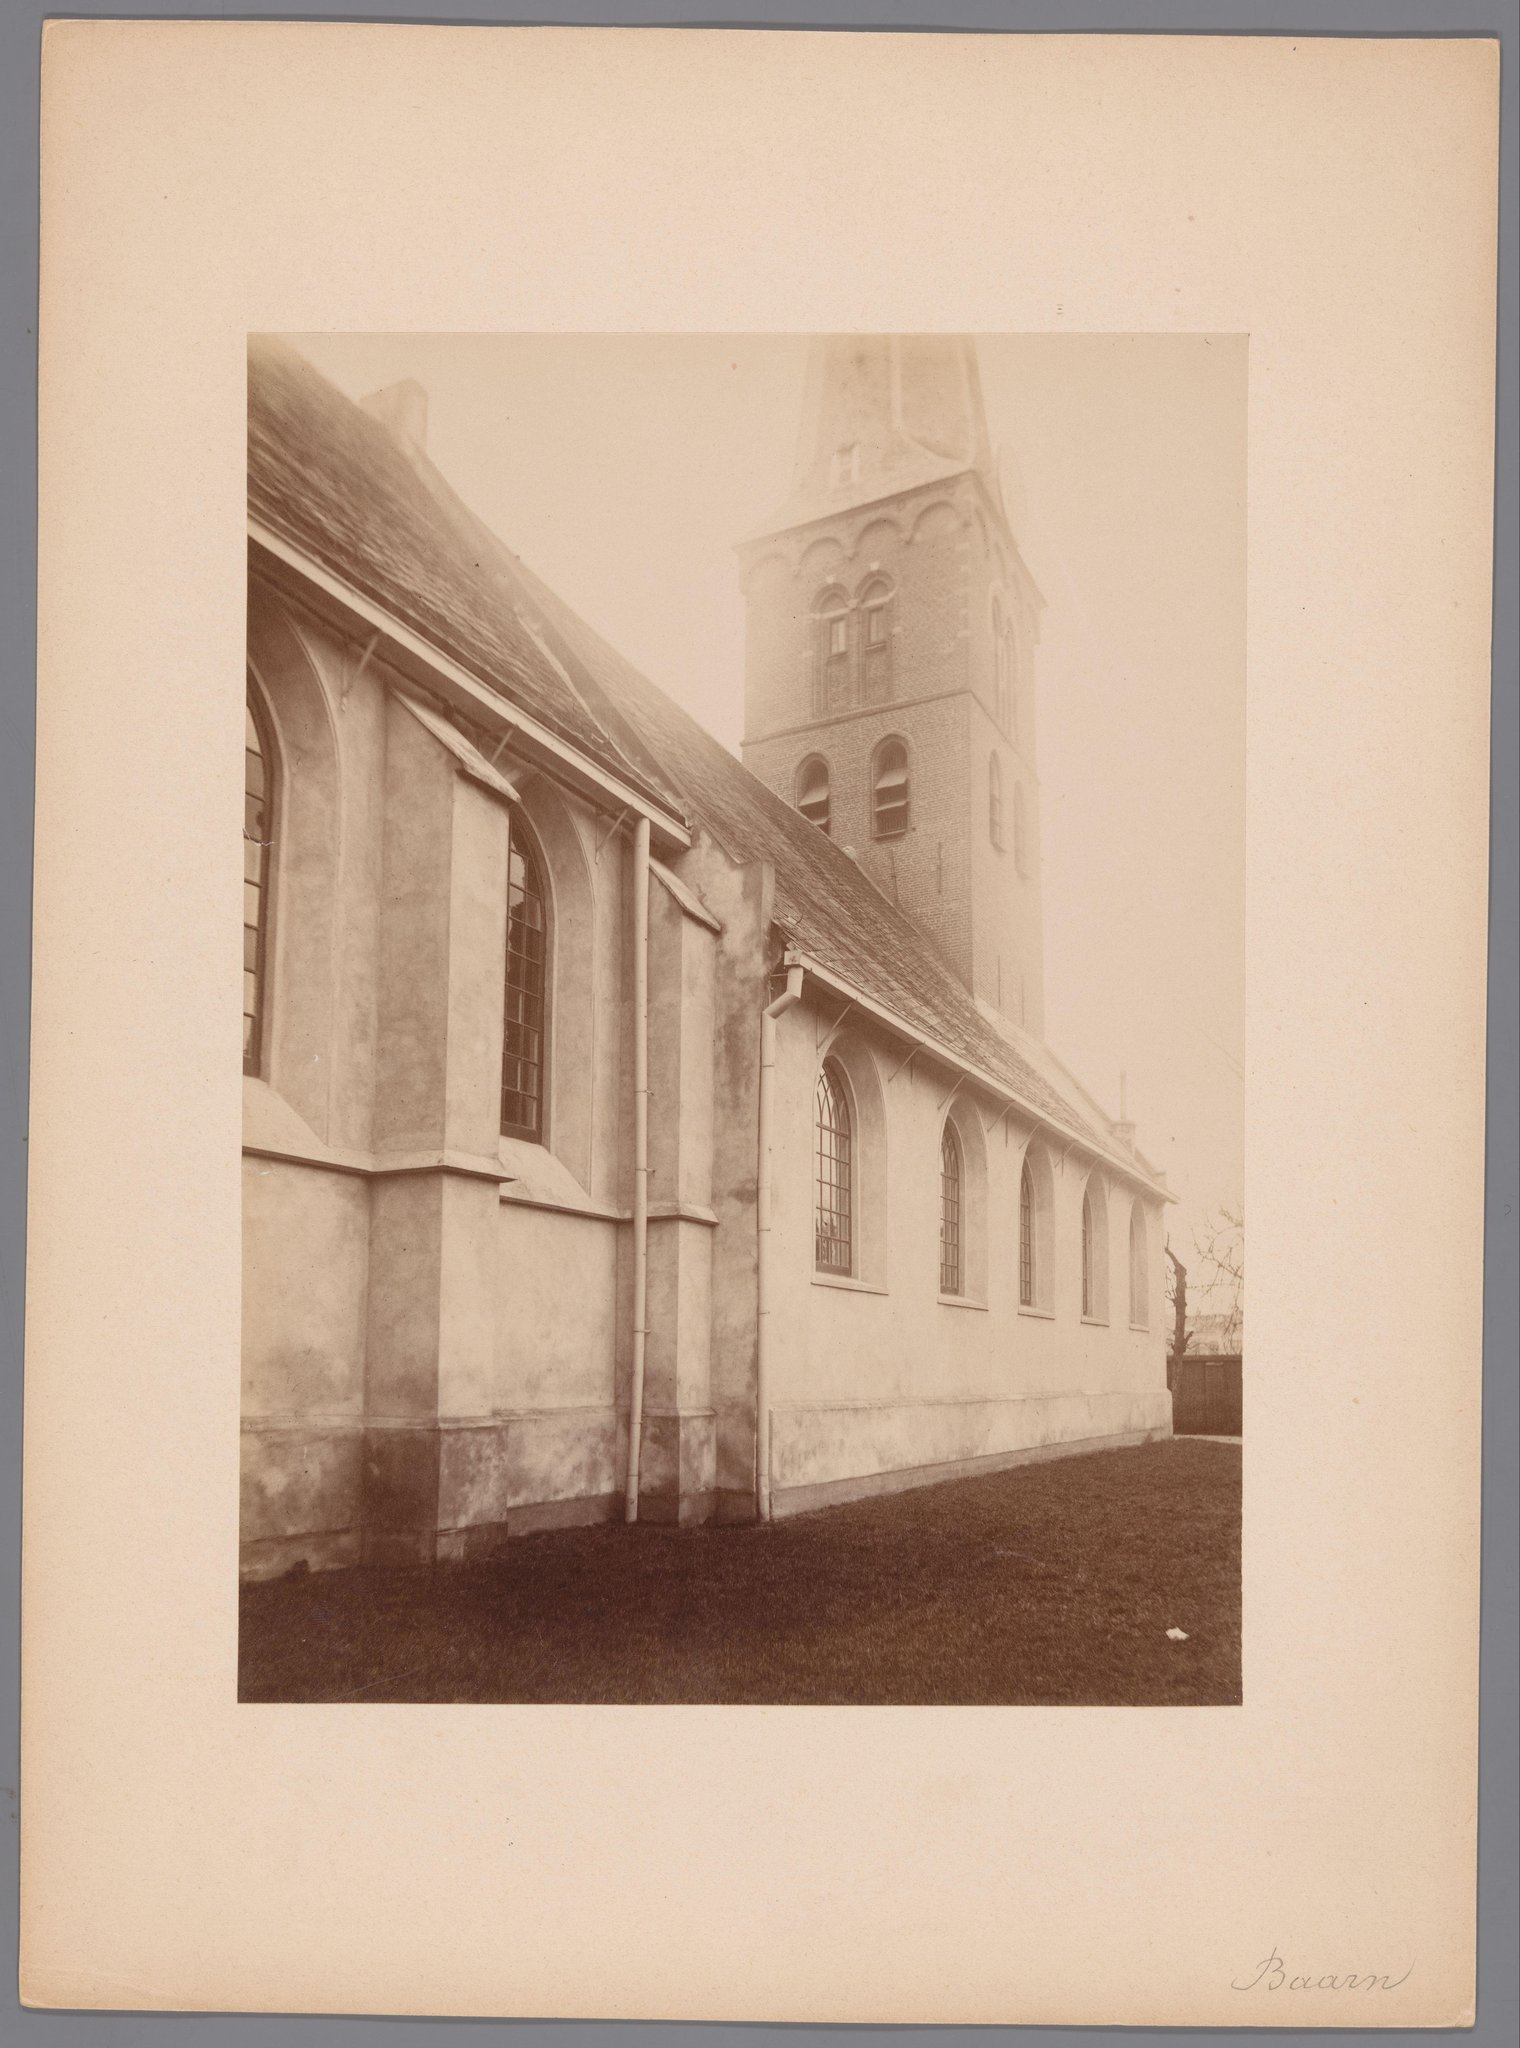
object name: photograph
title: Pauluskerk te Baarn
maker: anoniem (monumentenzorg)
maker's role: fotograaf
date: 1890-1920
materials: cardboard, photographic support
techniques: albumen print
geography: baarn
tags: church (exterior)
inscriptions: annotation: ‘Baarn’, annotation: ‘Baarn/ N.H. Kerk’